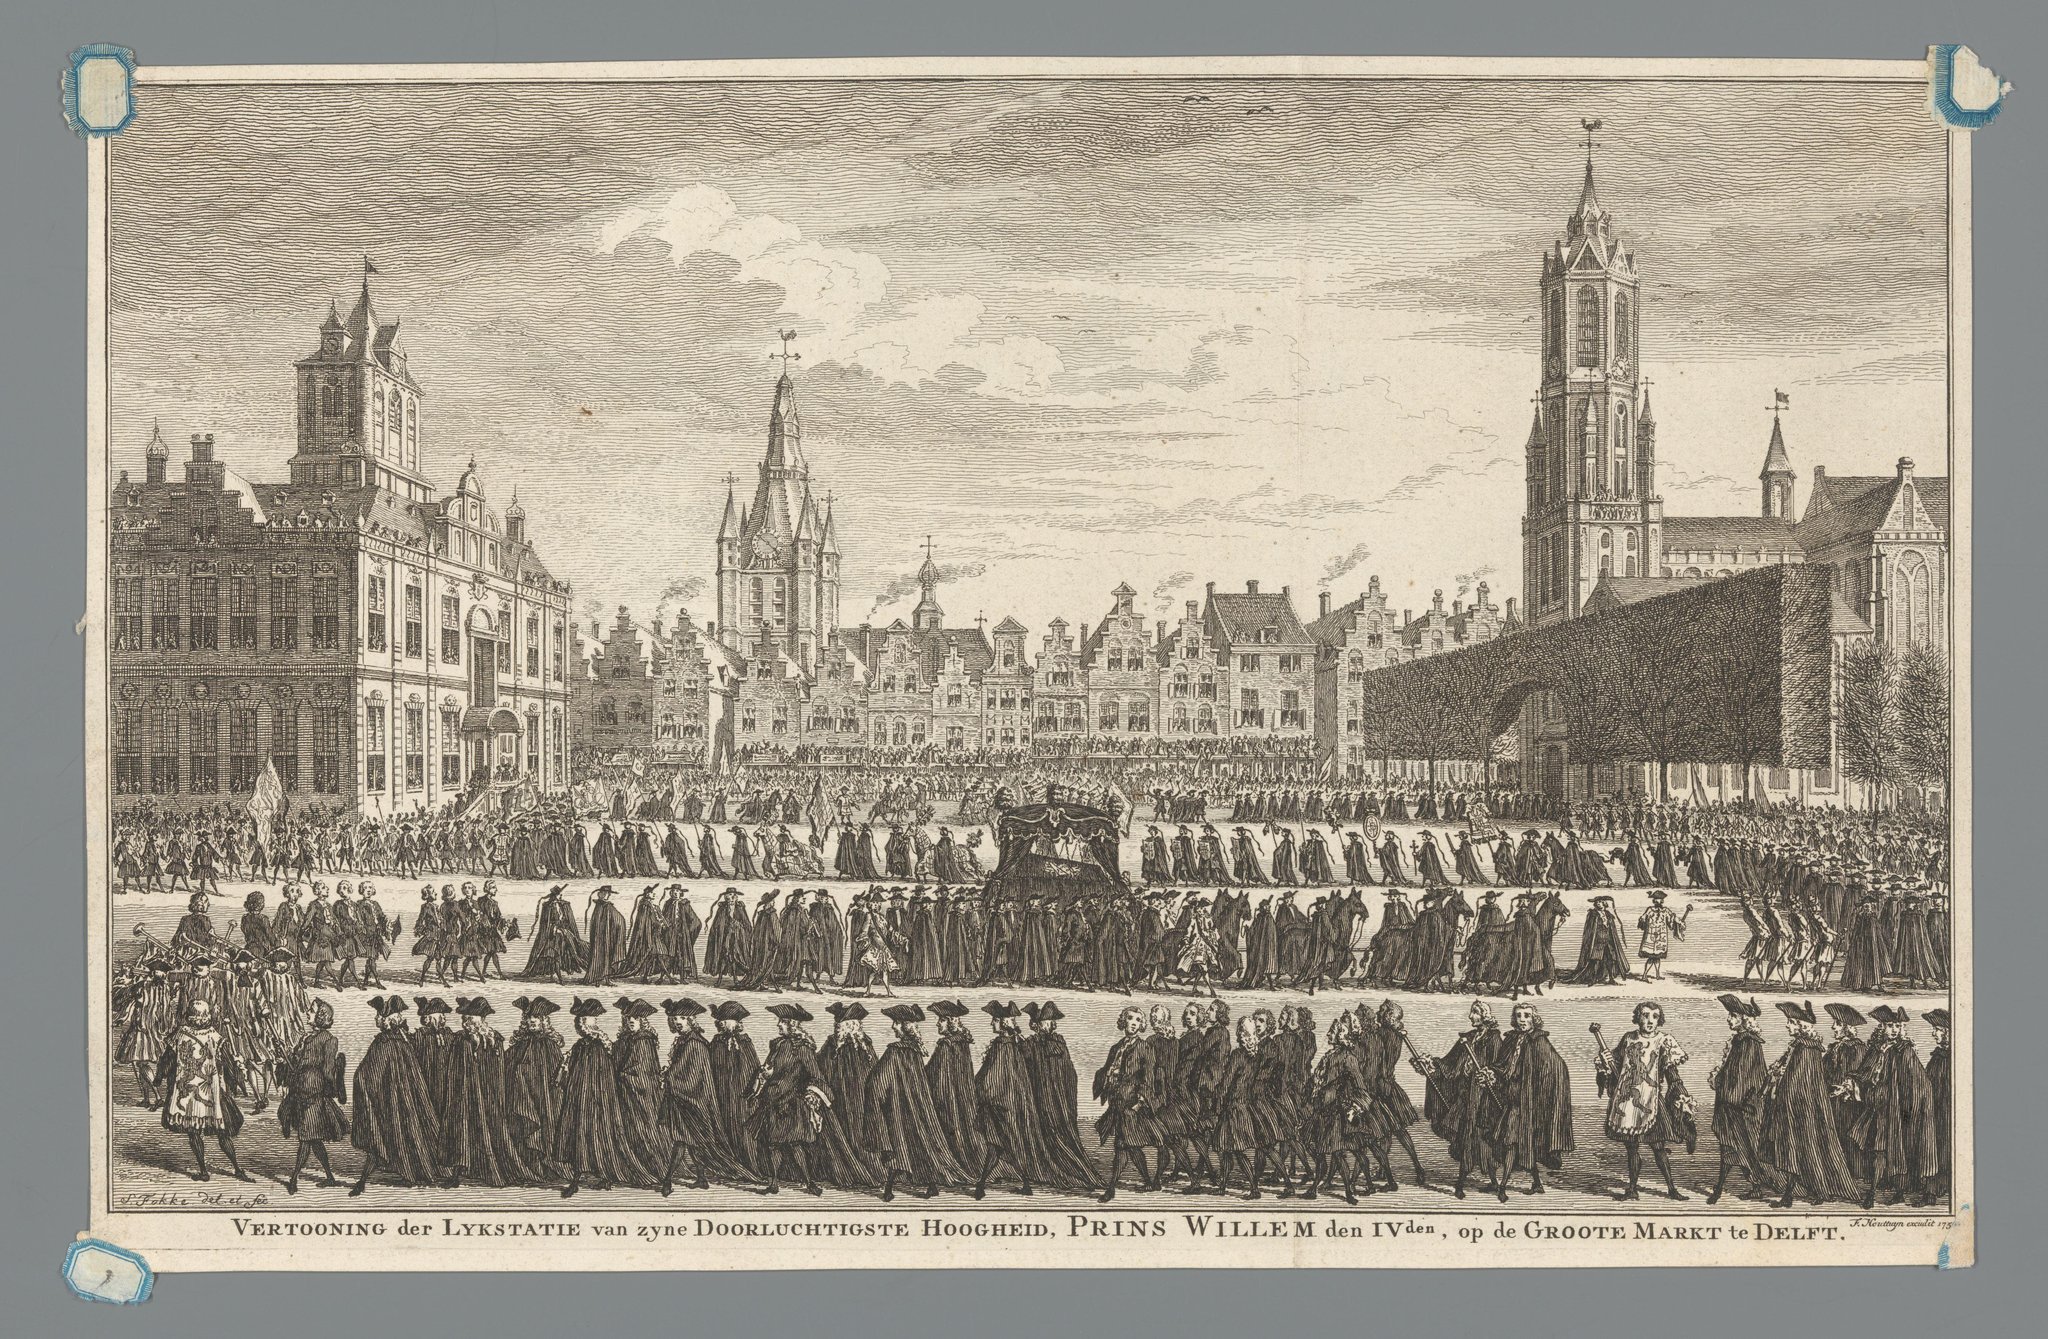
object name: print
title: Vertooning der lykstatie van zyne Doorluchtigste Hoogheid, prins Willem den IVden, op de Groote Markt te Delft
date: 1752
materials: paper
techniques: etching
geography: amsterdam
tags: the hague, willem iv (prins van oranje-nassau), cortege, funeral procession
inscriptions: date